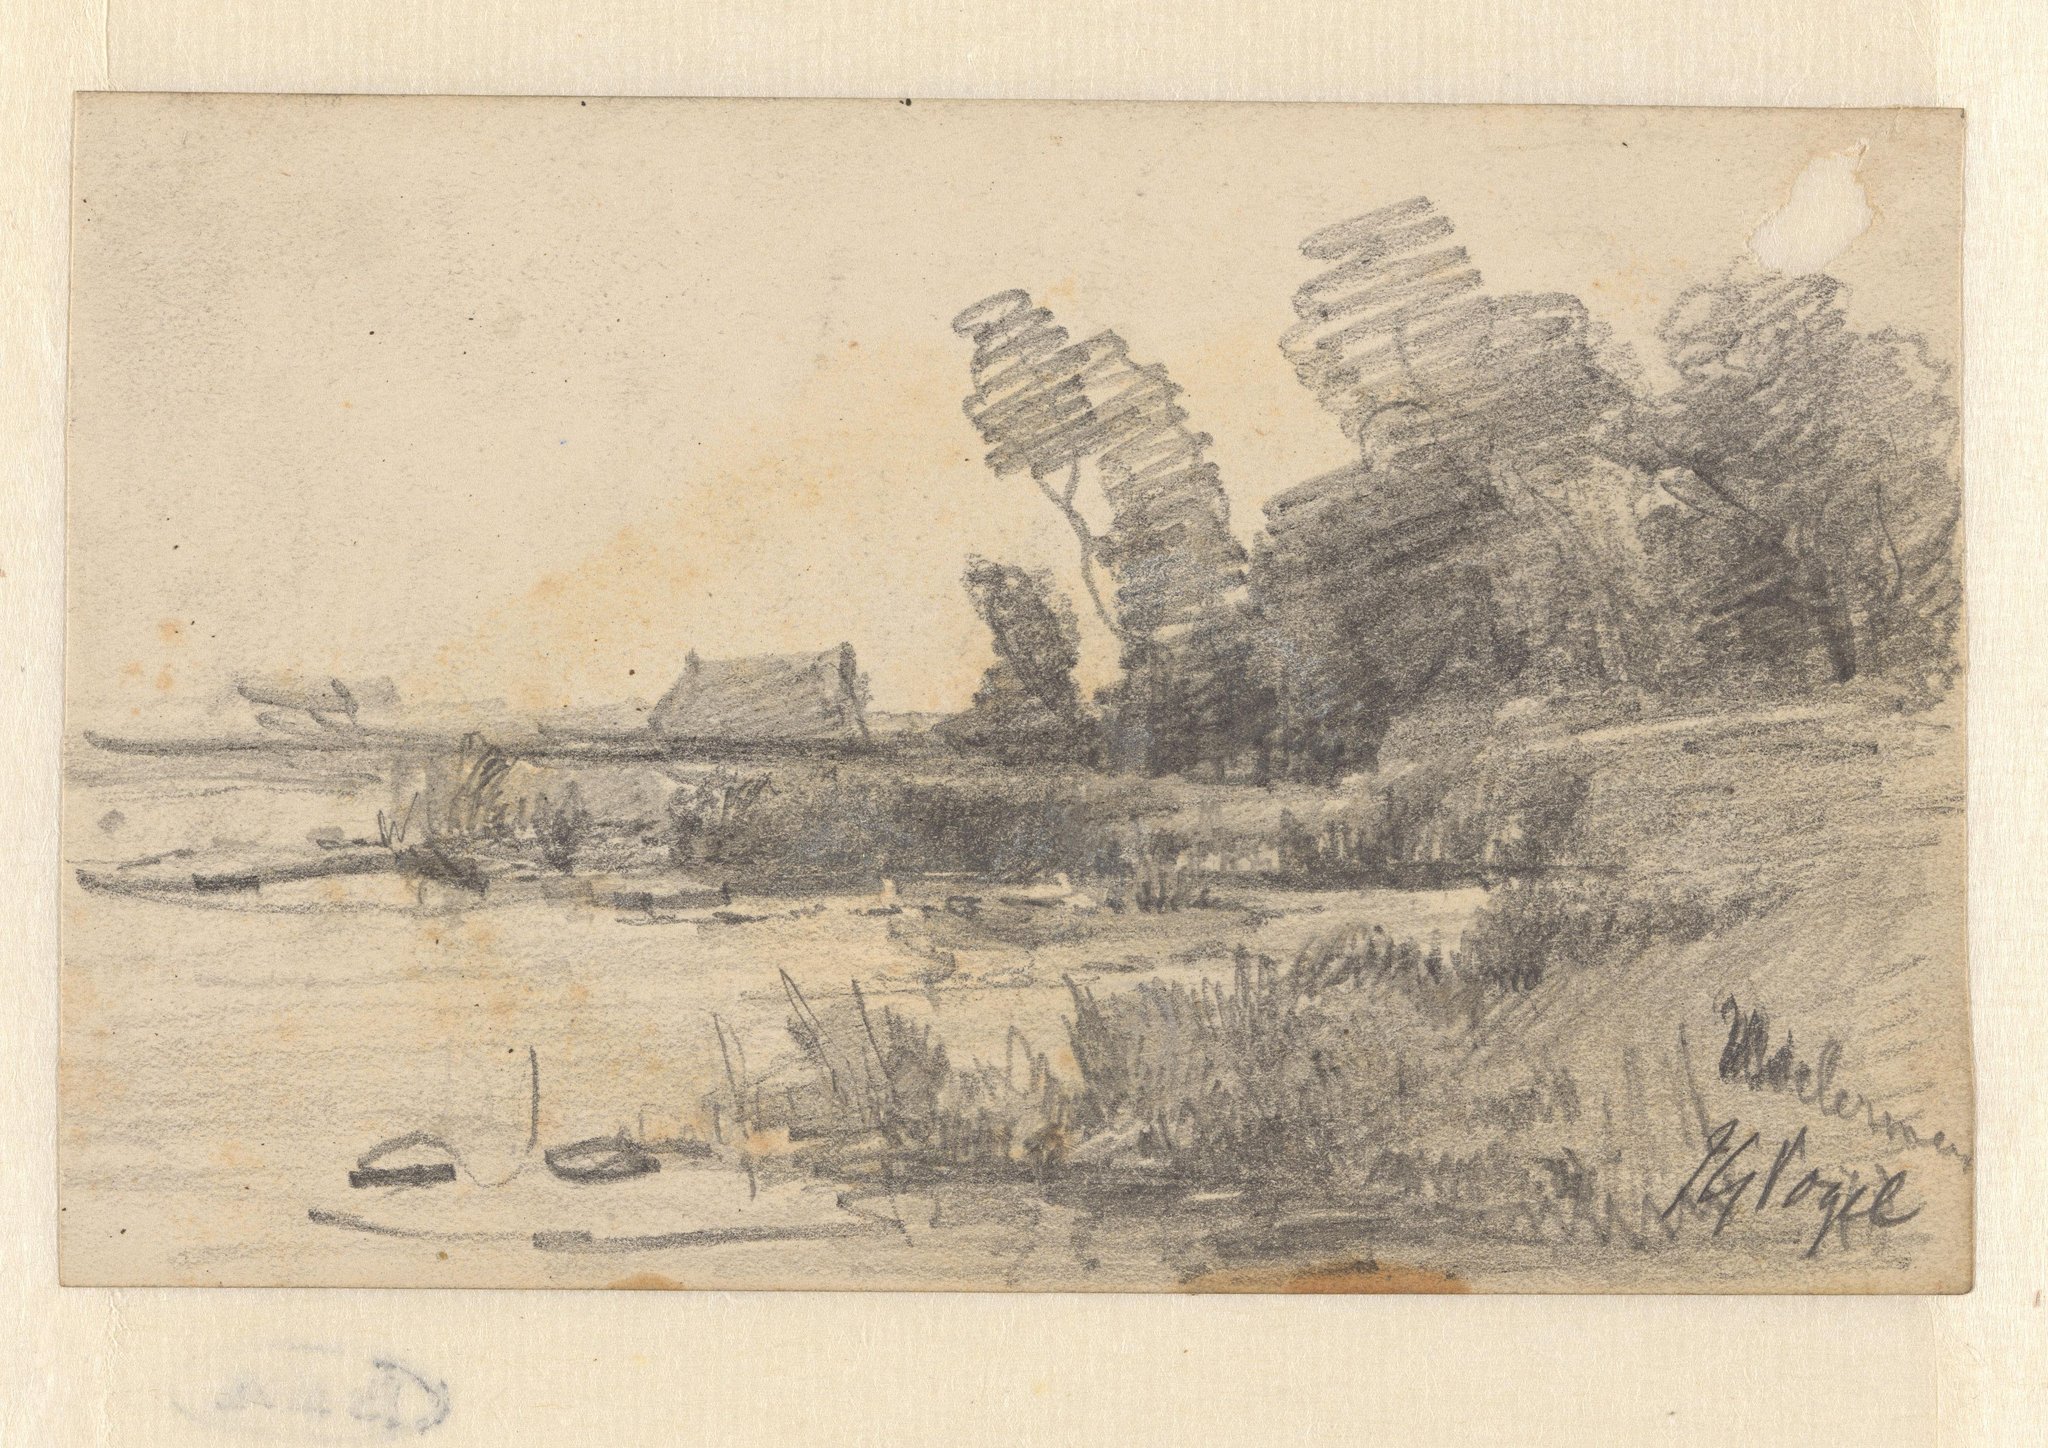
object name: drawing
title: Huis langs een meer, mogelijk het Uddelermeer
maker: johannes gijsbert vogel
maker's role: draughtsman, painter, print maker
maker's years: 1828-1915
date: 1838-1915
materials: paper, pencil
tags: landscapes with waters, waterscapes, seascapes (in the temperate zone), farm or solitary house in landscape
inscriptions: annotation: ‘U[...]delerme[...]’, collector's mark: Lugt 1181b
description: Op verso een fragment van een potloodschets.